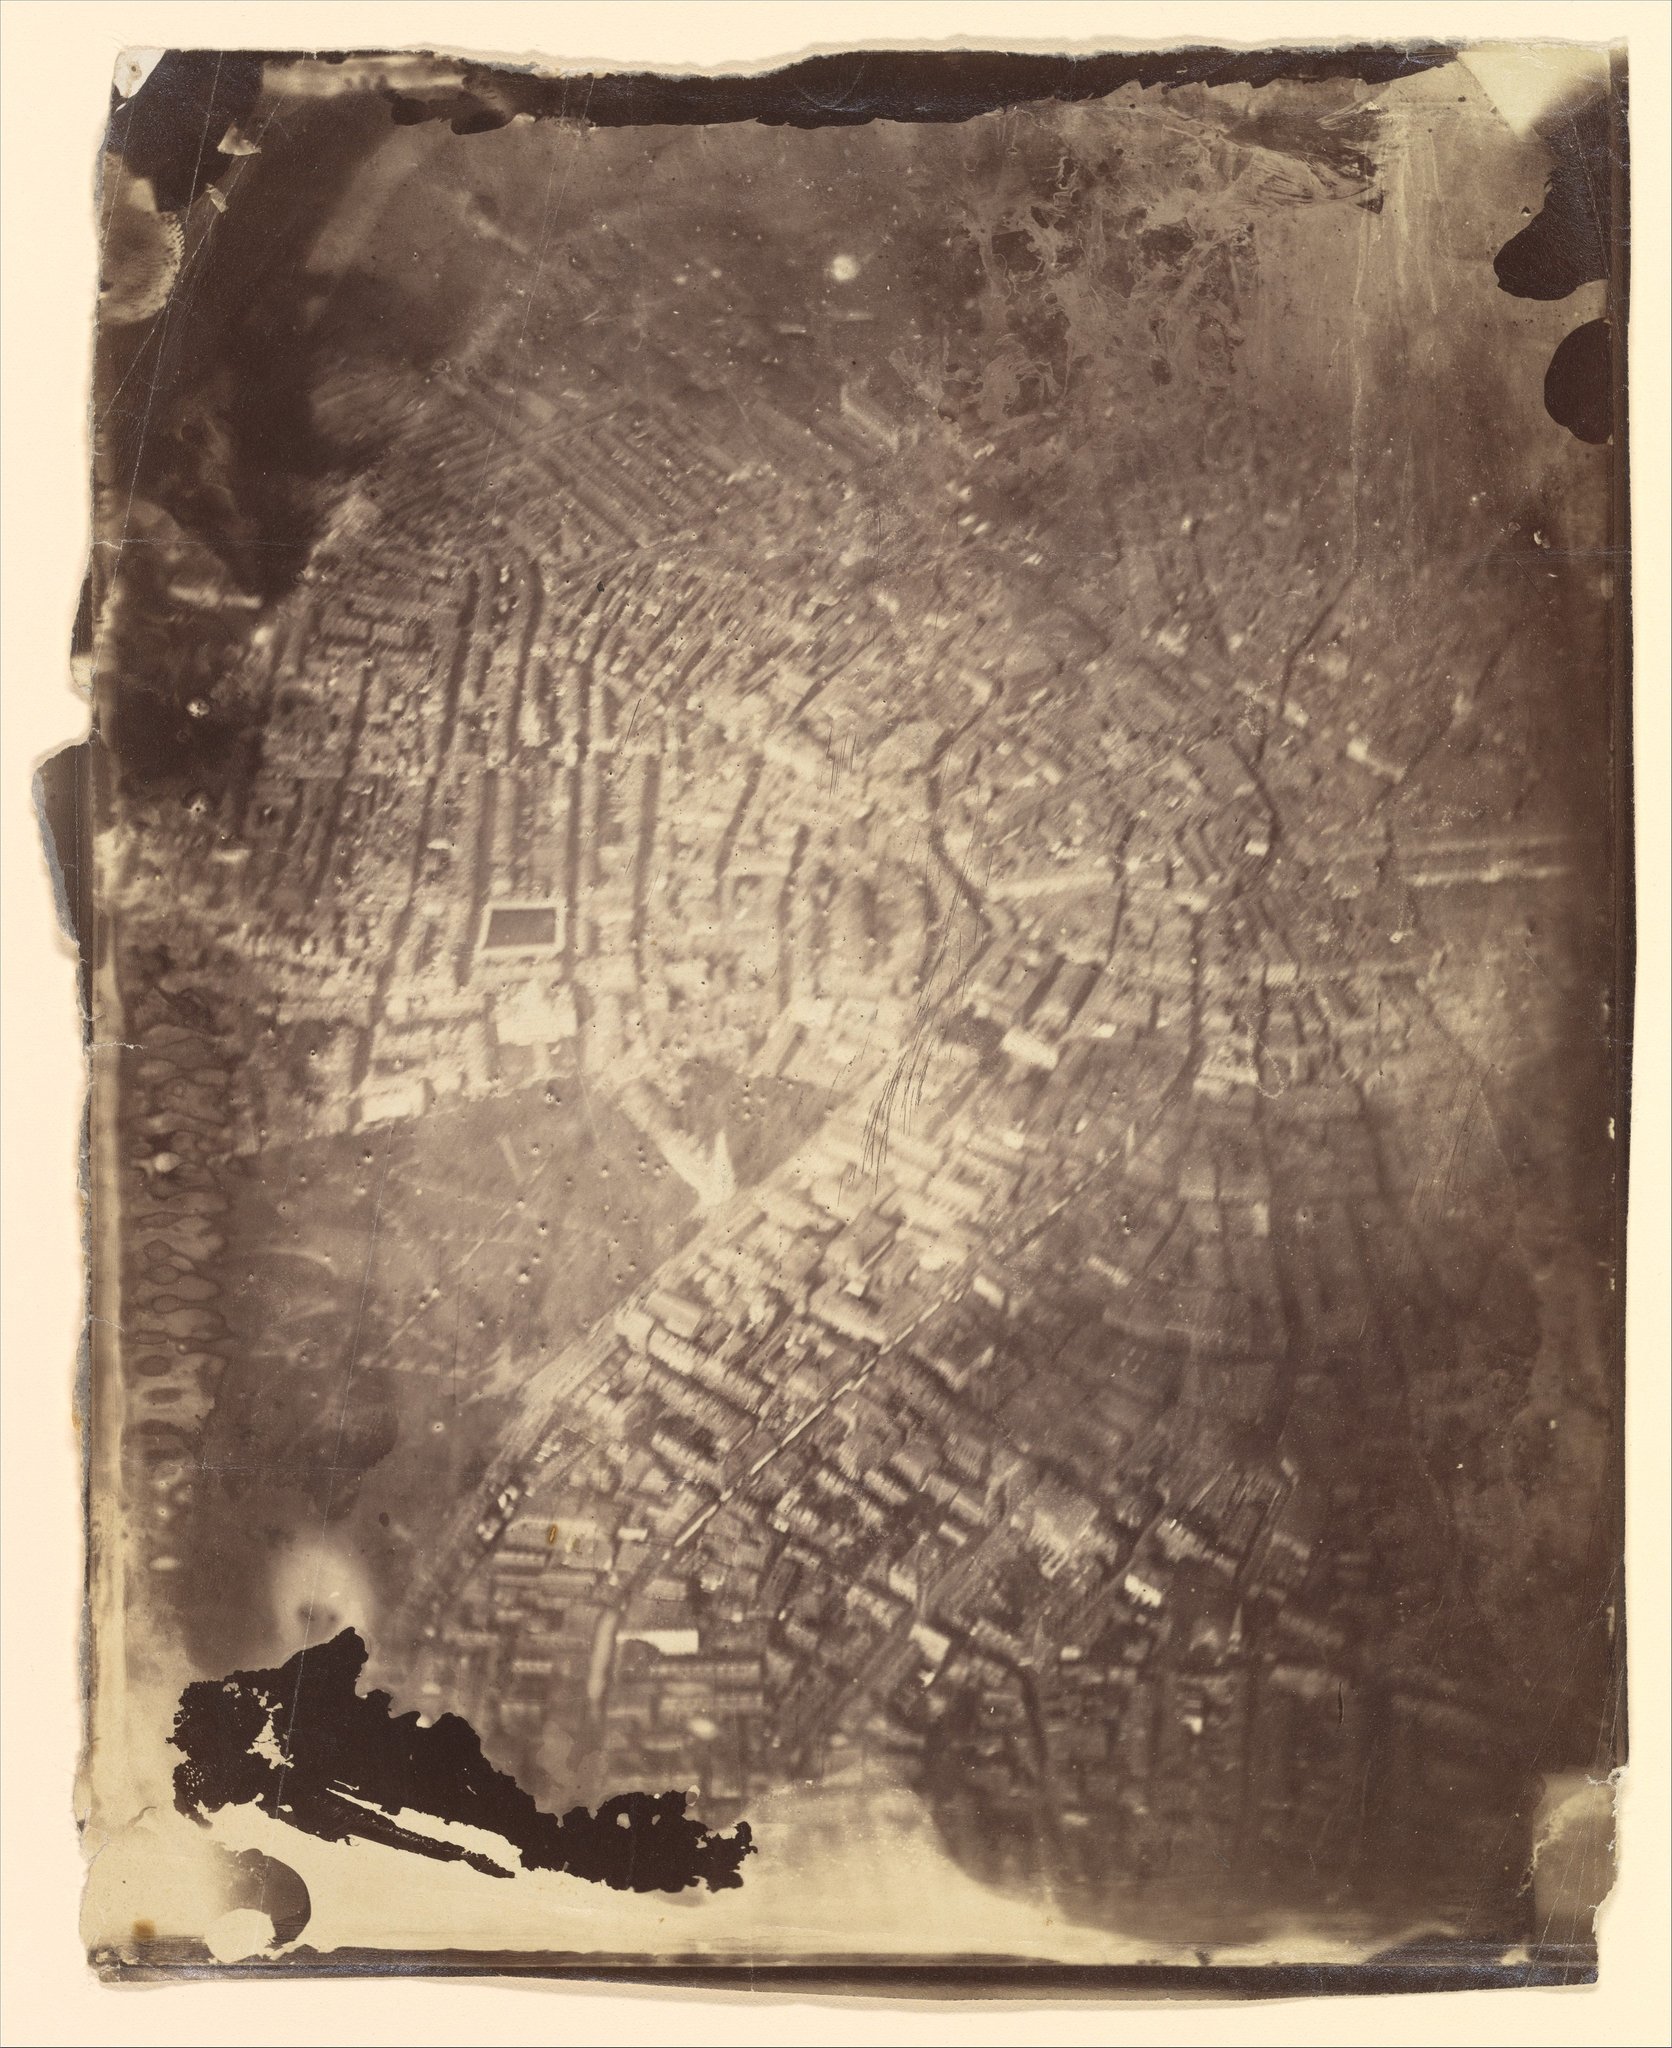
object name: photograph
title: [Boston from a Hot-Air Balloon]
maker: james wallace black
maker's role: artist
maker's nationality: american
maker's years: 1825-1896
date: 1860-1869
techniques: albumen silver print, glass negative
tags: cities